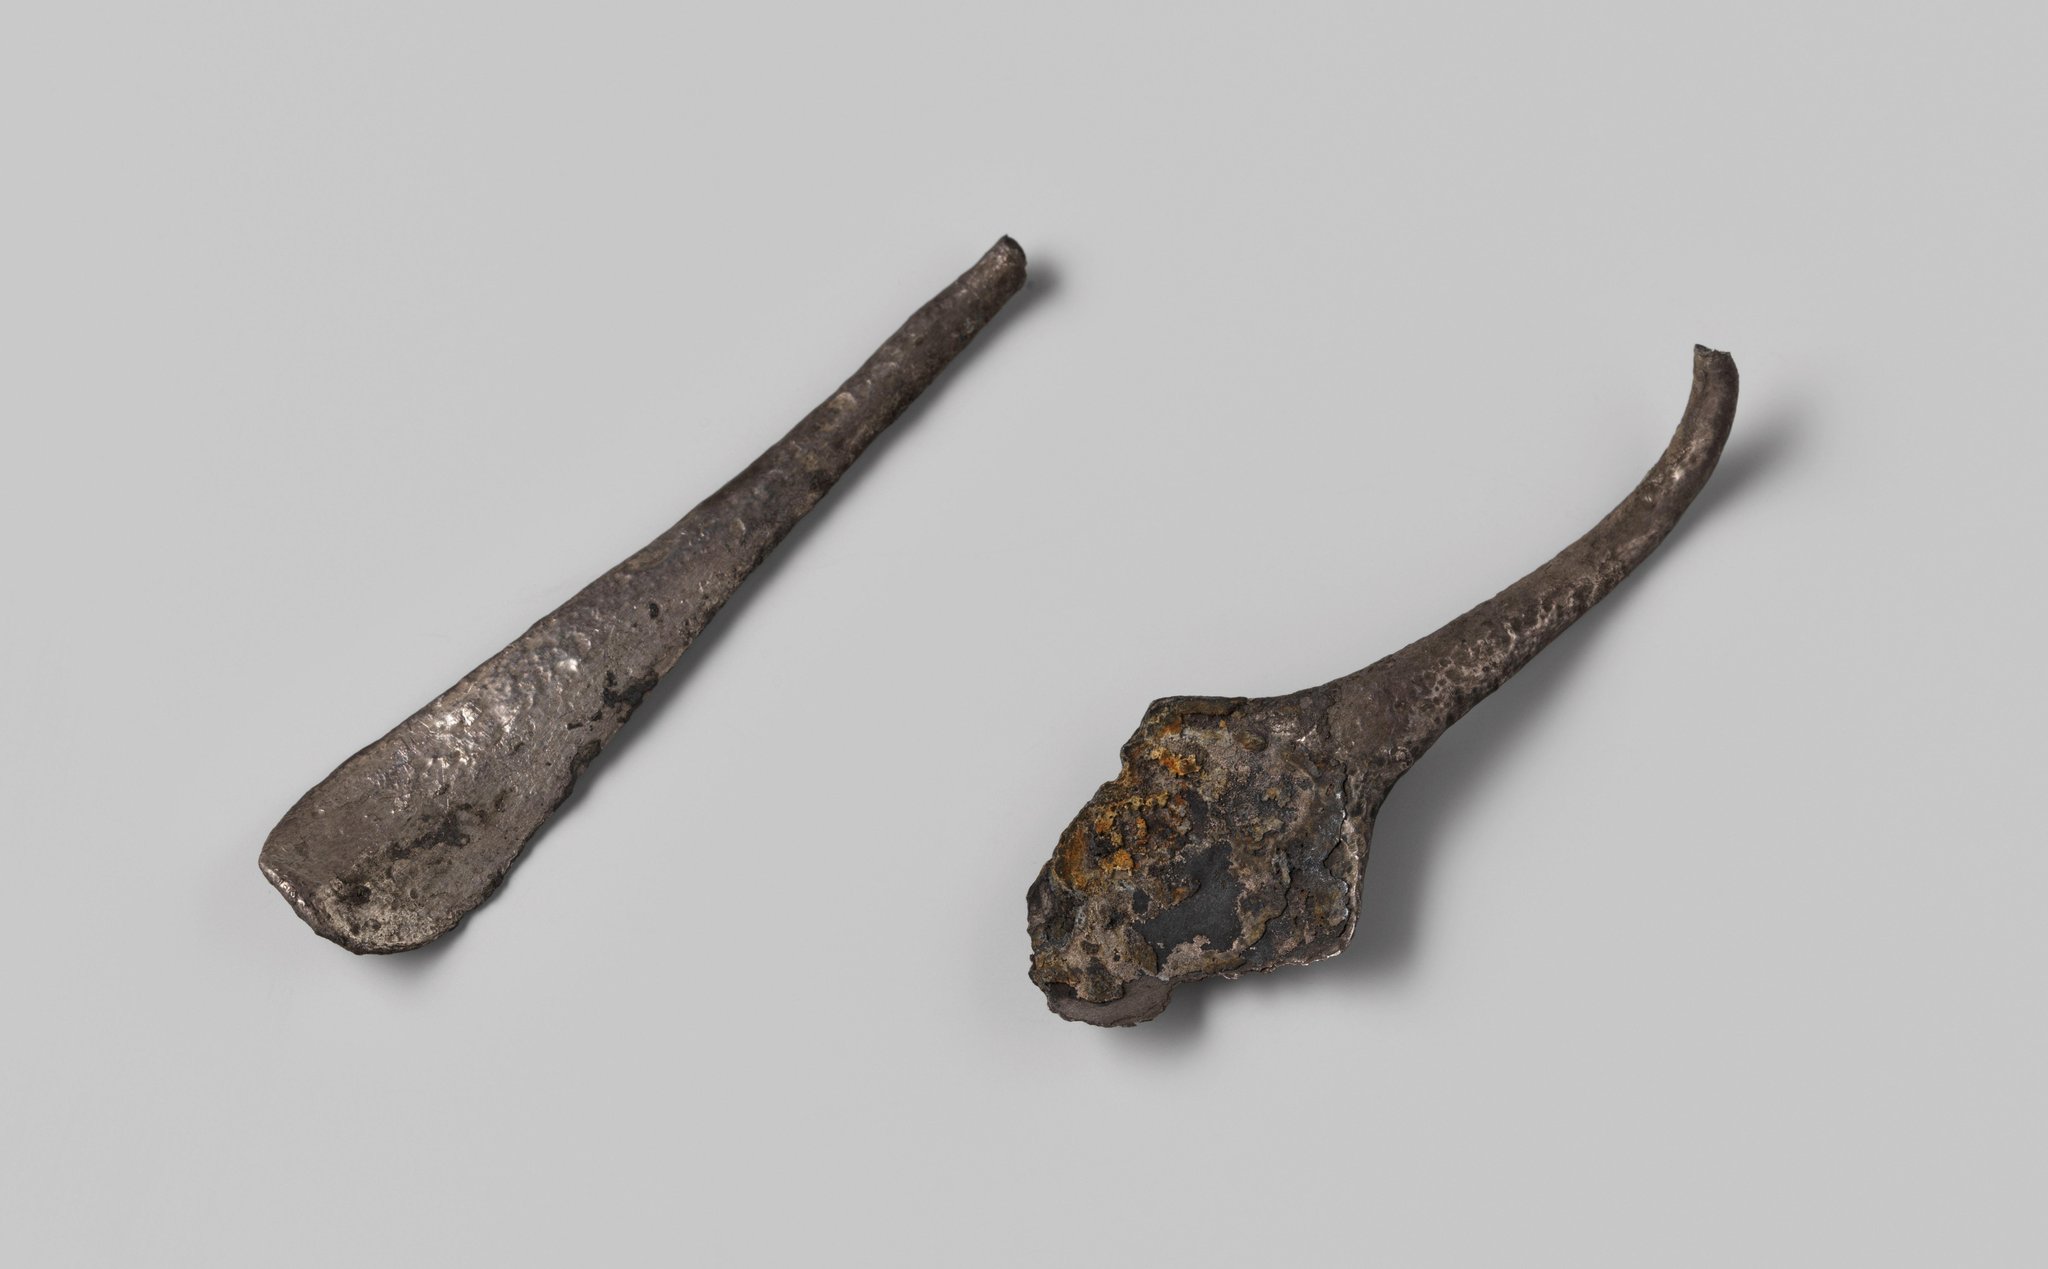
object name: spoon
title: Gebroken lepel uit het wrak van de Oost-Indiëvaarder Hollandia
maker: Anonymous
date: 1700-1743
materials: silver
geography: netherlands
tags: verenigde oostindische compagnie, hollandia (schip), annet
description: Cutlery, spoon; fragment, stem and bowl fragm, eroded, id. NG 1980-27H2608, marks illegible.